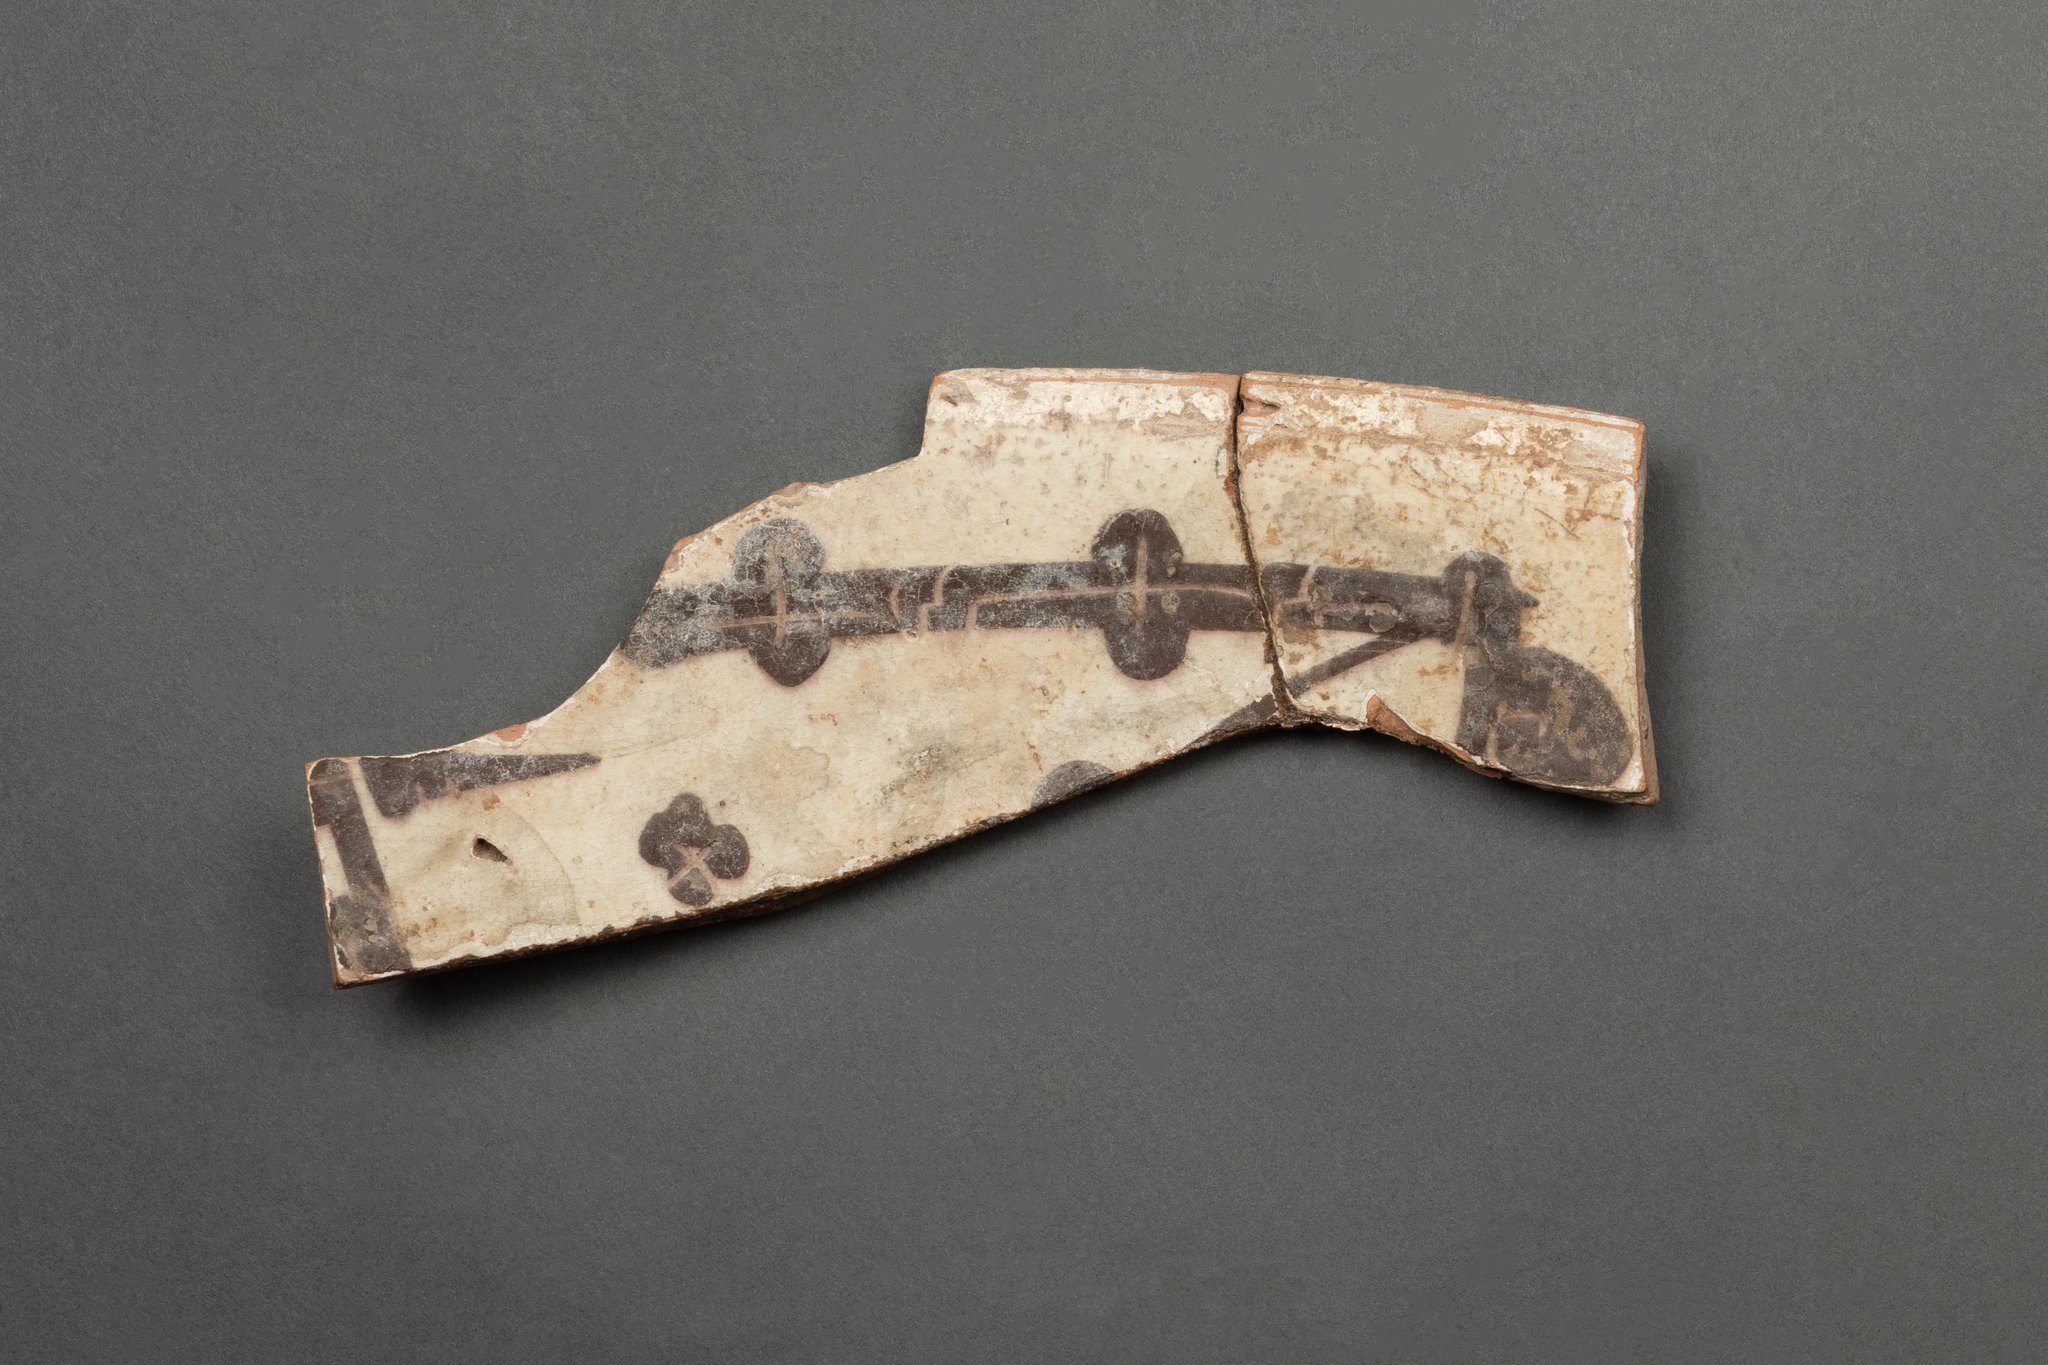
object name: fragment of a bowl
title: Fragments of a Bowl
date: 901-1000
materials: earthenware, glaze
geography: iran